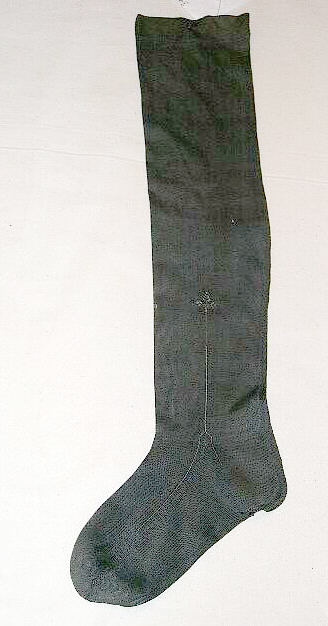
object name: stocking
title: Stockings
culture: american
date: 1800-1939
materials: silk